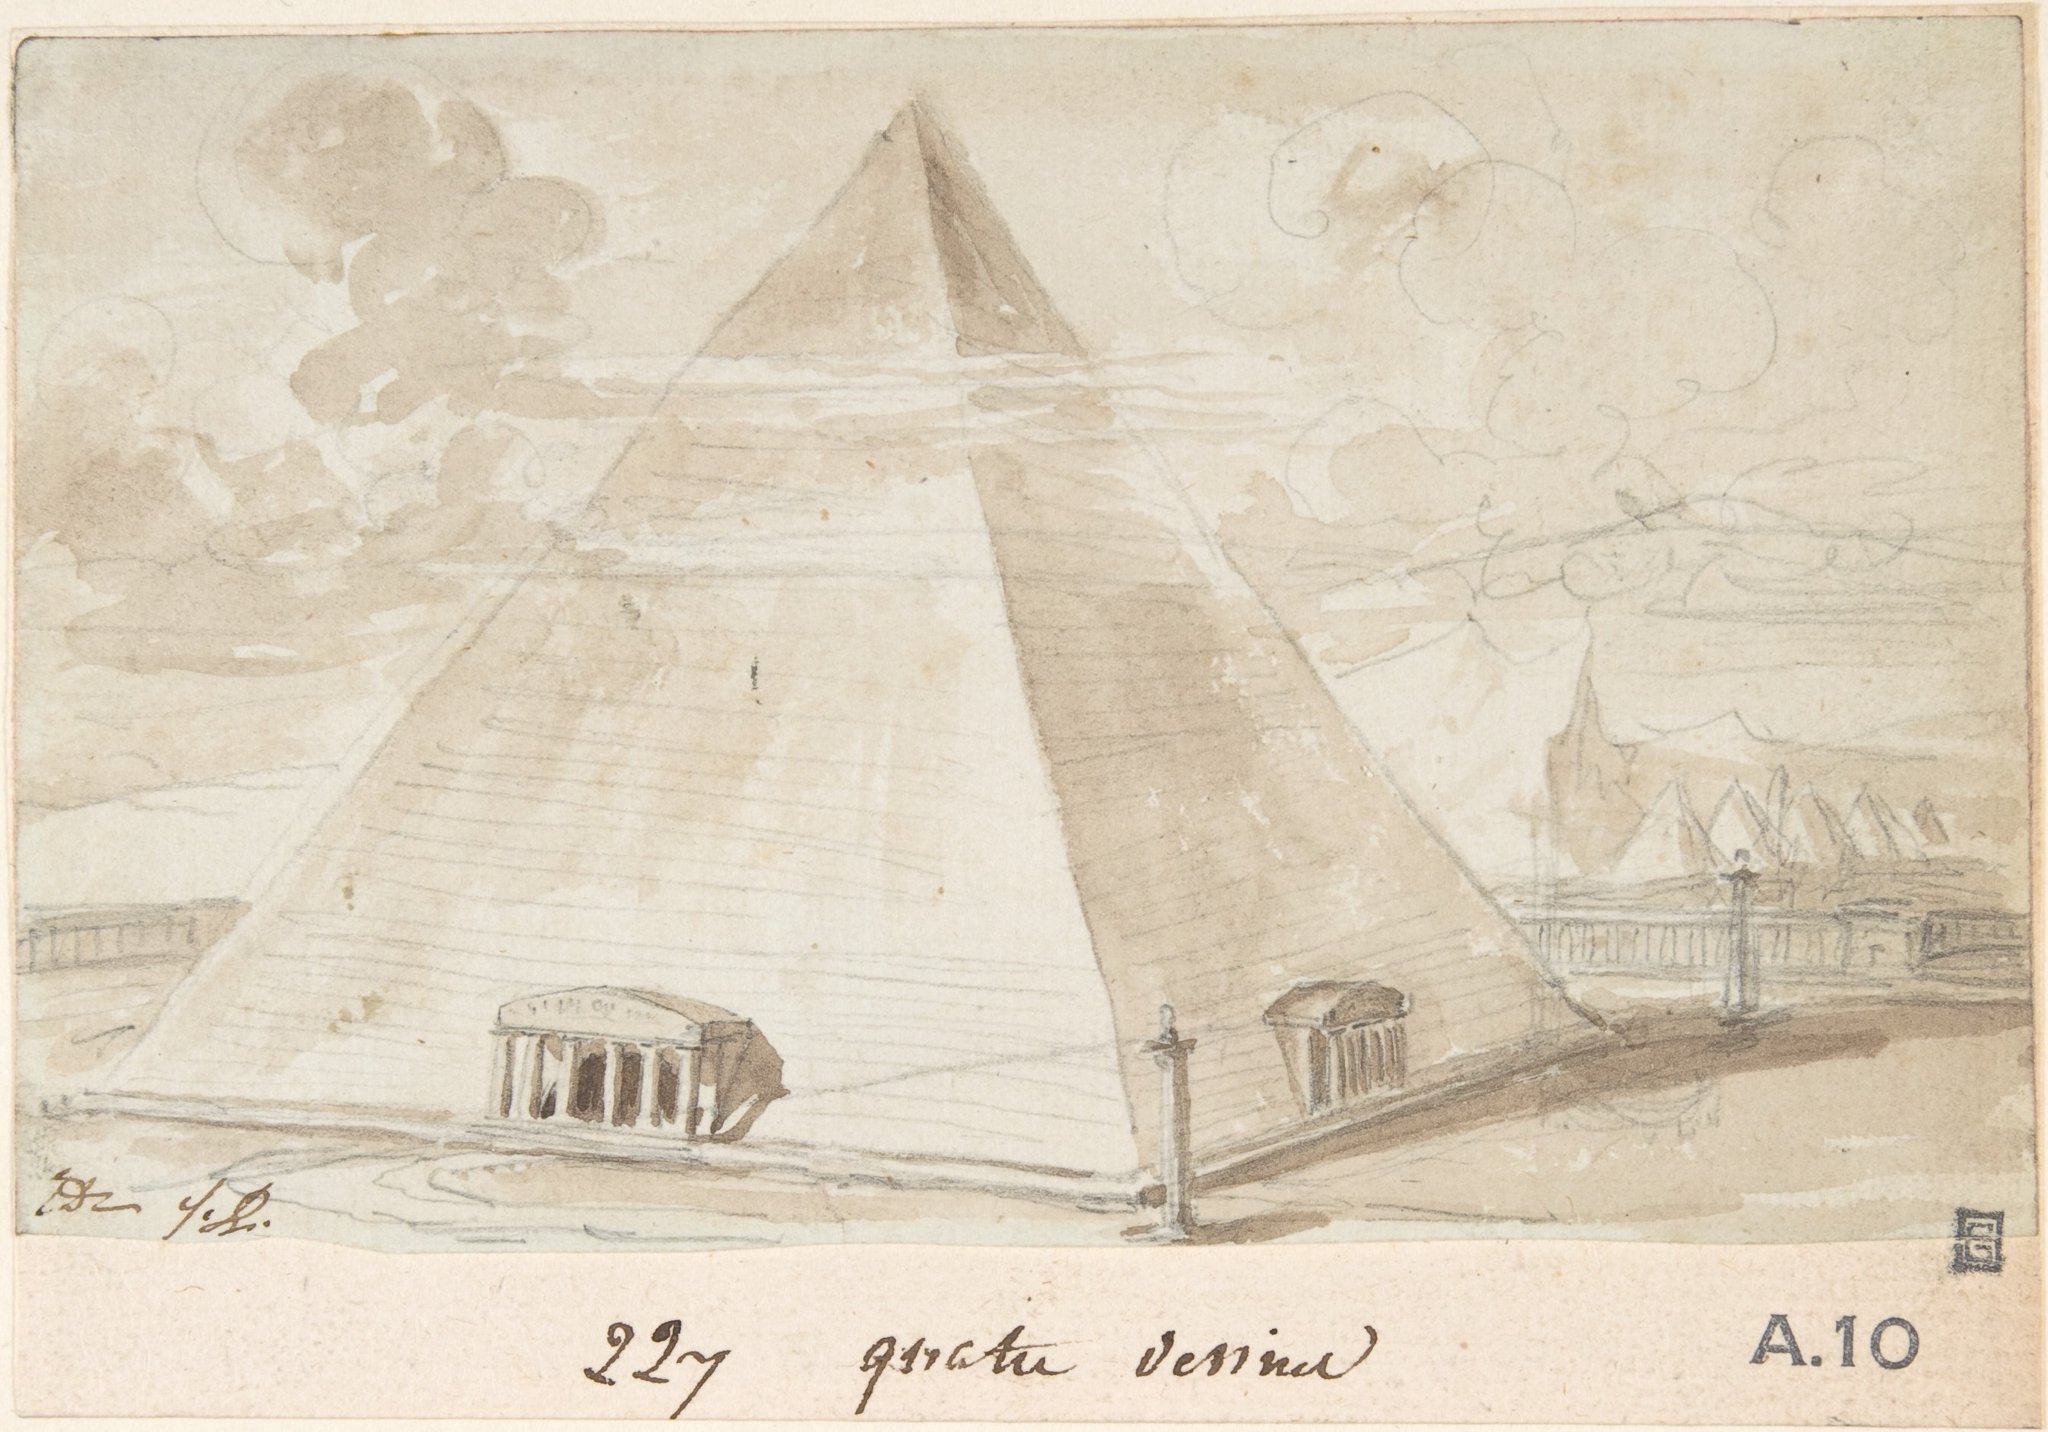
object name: drawing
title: Study of a Pyramid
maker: jacques louis david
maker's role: artist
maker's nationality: french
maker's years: 1748-1825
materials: graphite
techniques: brush, wash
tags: pyramids